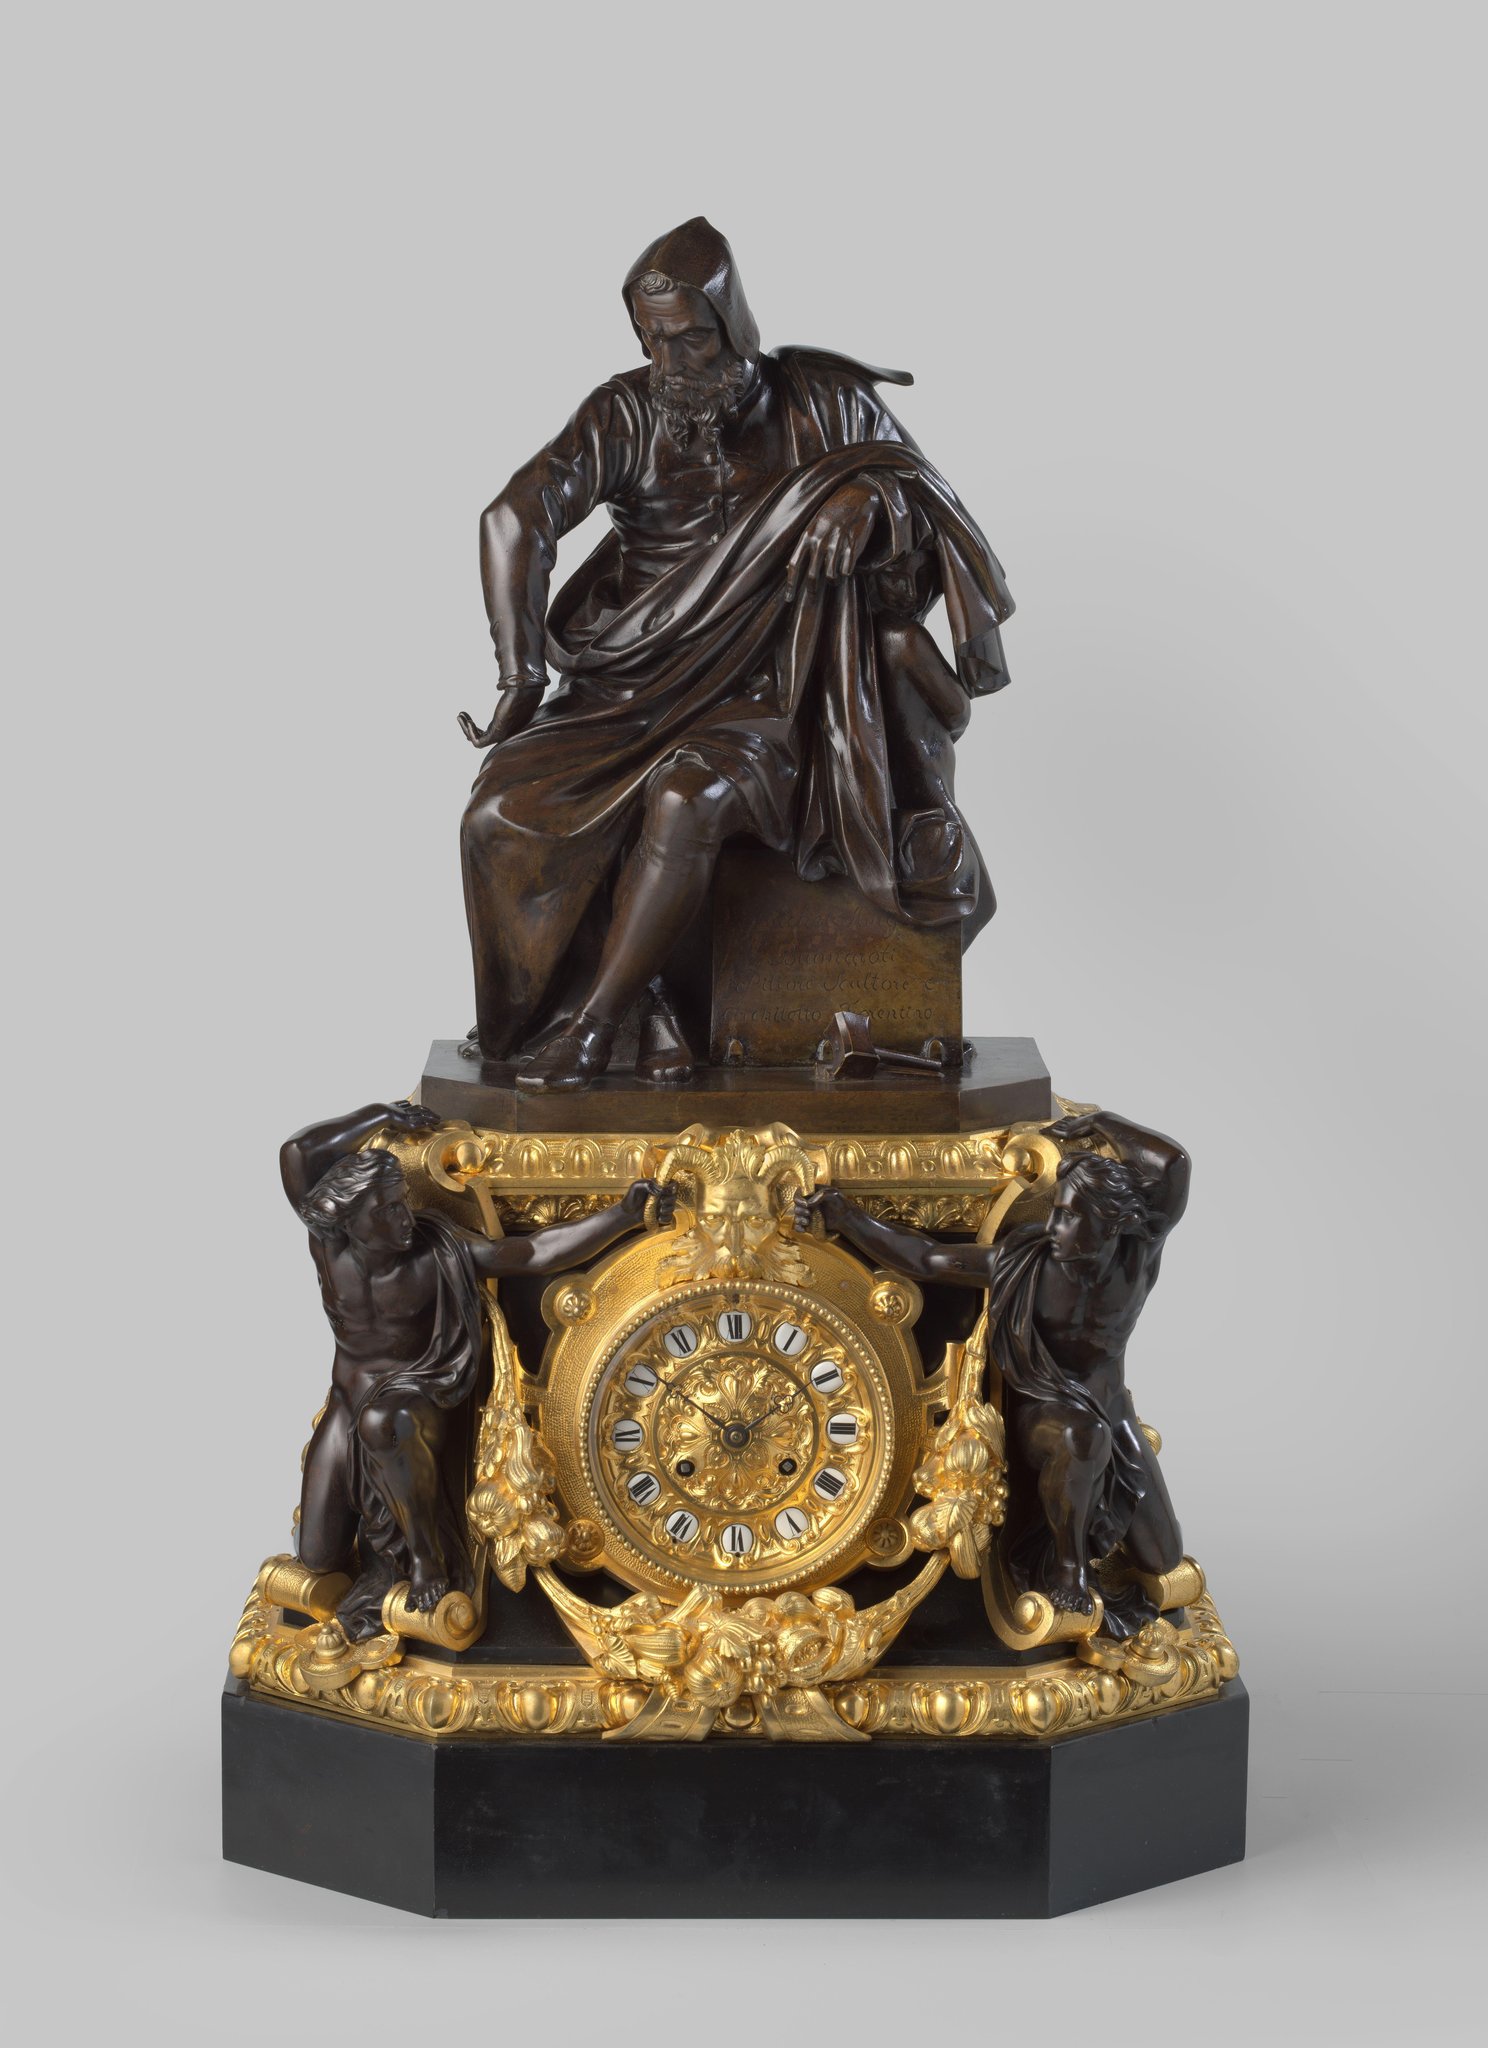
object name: clock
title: Mantel clock ‘Michelangelo’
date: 1849-1852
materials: bronze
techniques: gilding, patinaed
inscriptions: inscription: ‘Michel Ange Buonaroti Scultore e Architetto Fiorentino’, signature: ‘J Feuchere scpt en Vittoz bronzier’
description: Bronze statues of famous figures from the past became very popular in the first half of the 19th century. This clock is conceived as a monument for Michelangelo. The artist is meditating, his arm supported by a statue on which he has been working. His tools lie by him. The ornamentation of the case is in the Renaissance style.